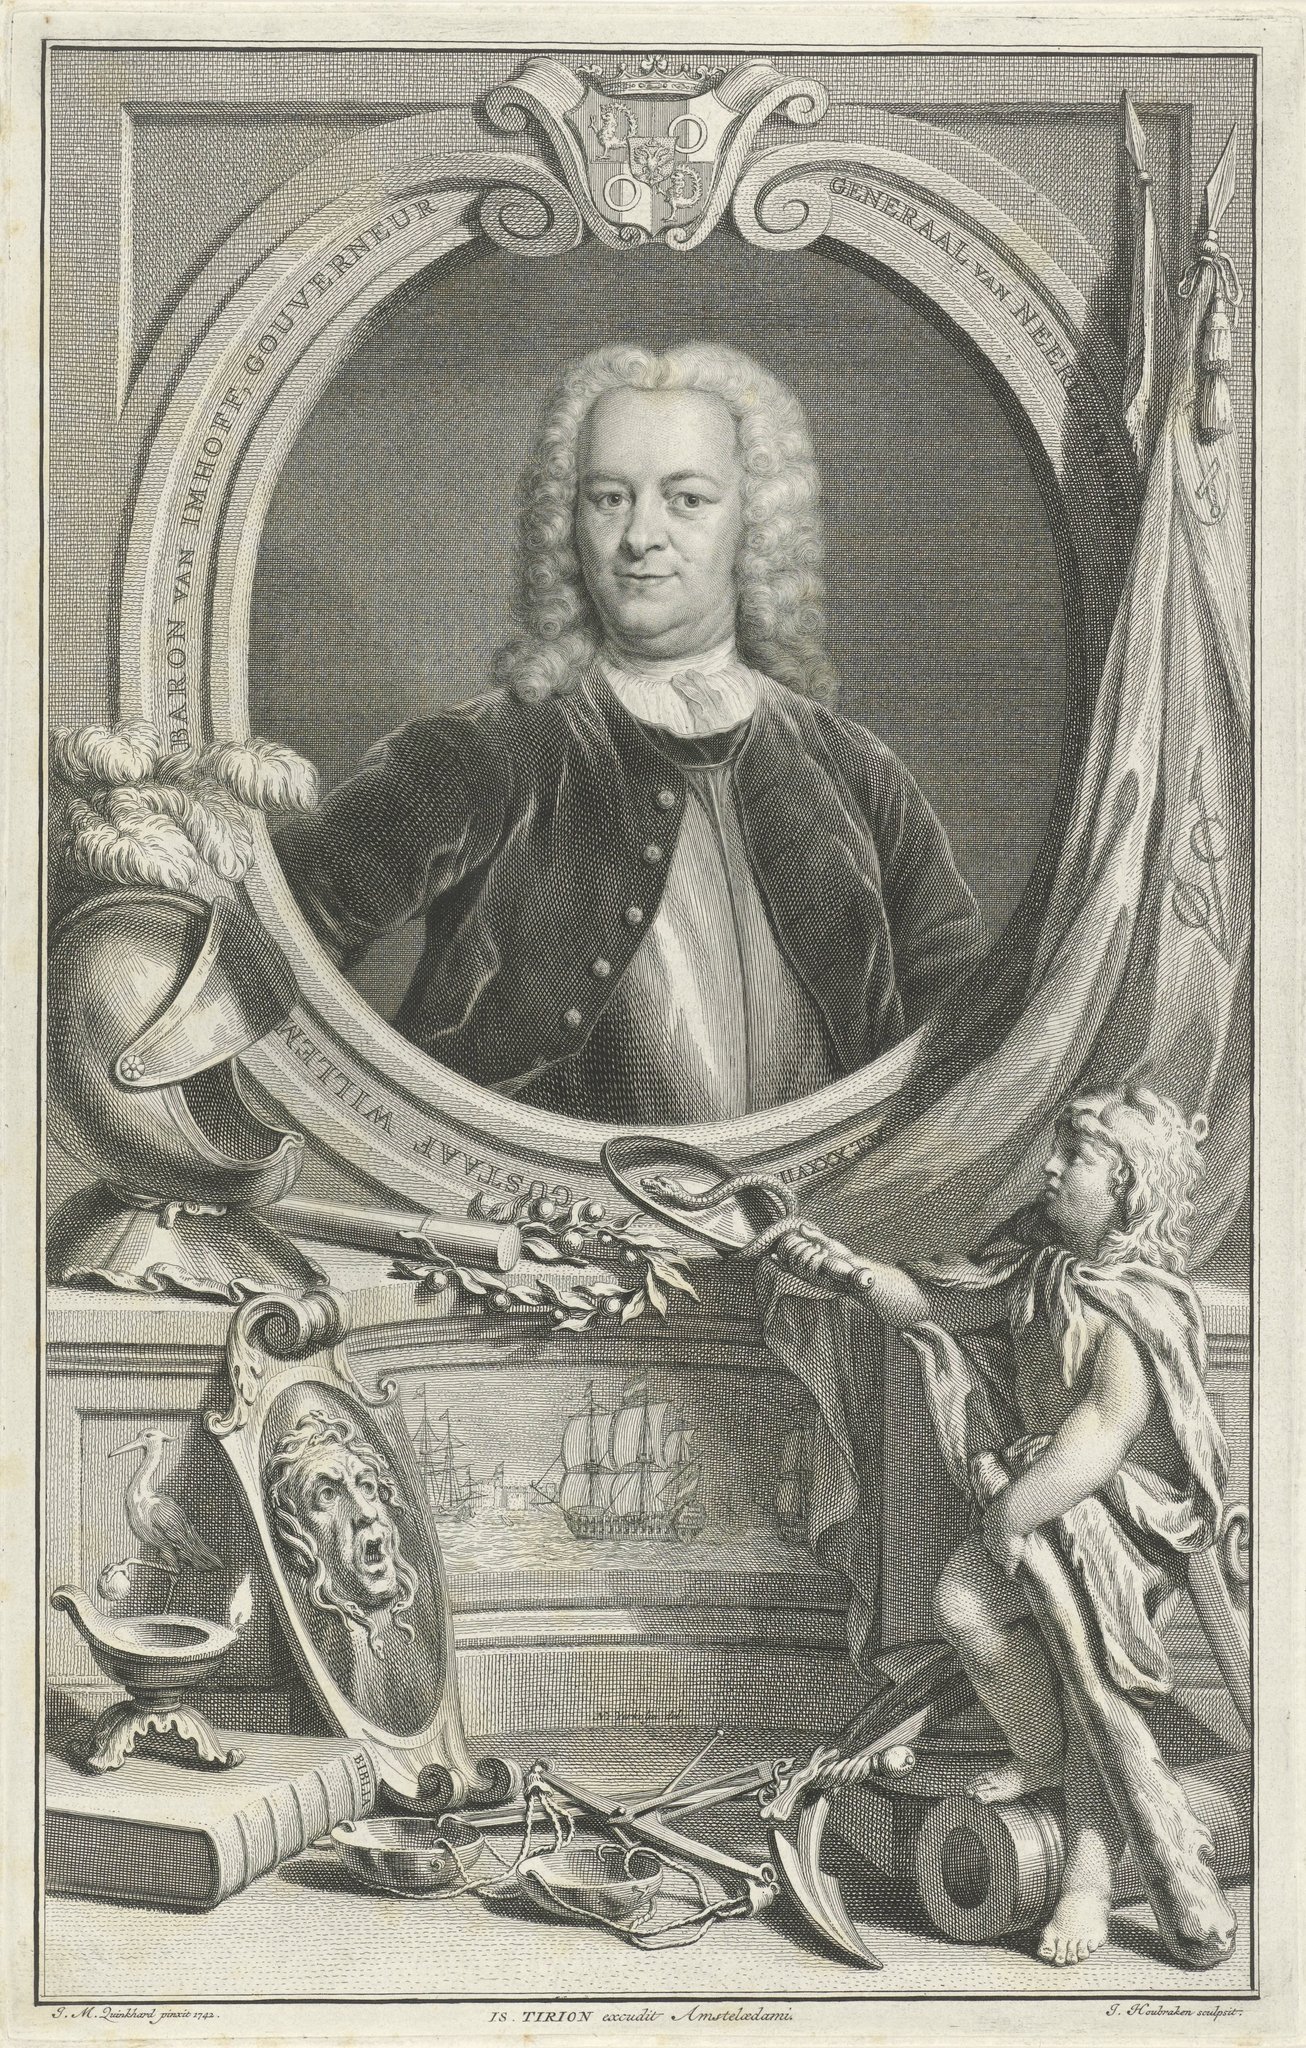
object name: print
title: Portret van Gustaaf Willem Baron van Imhoff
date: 1741-1780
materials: paper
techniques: engraving, etching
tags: batavia